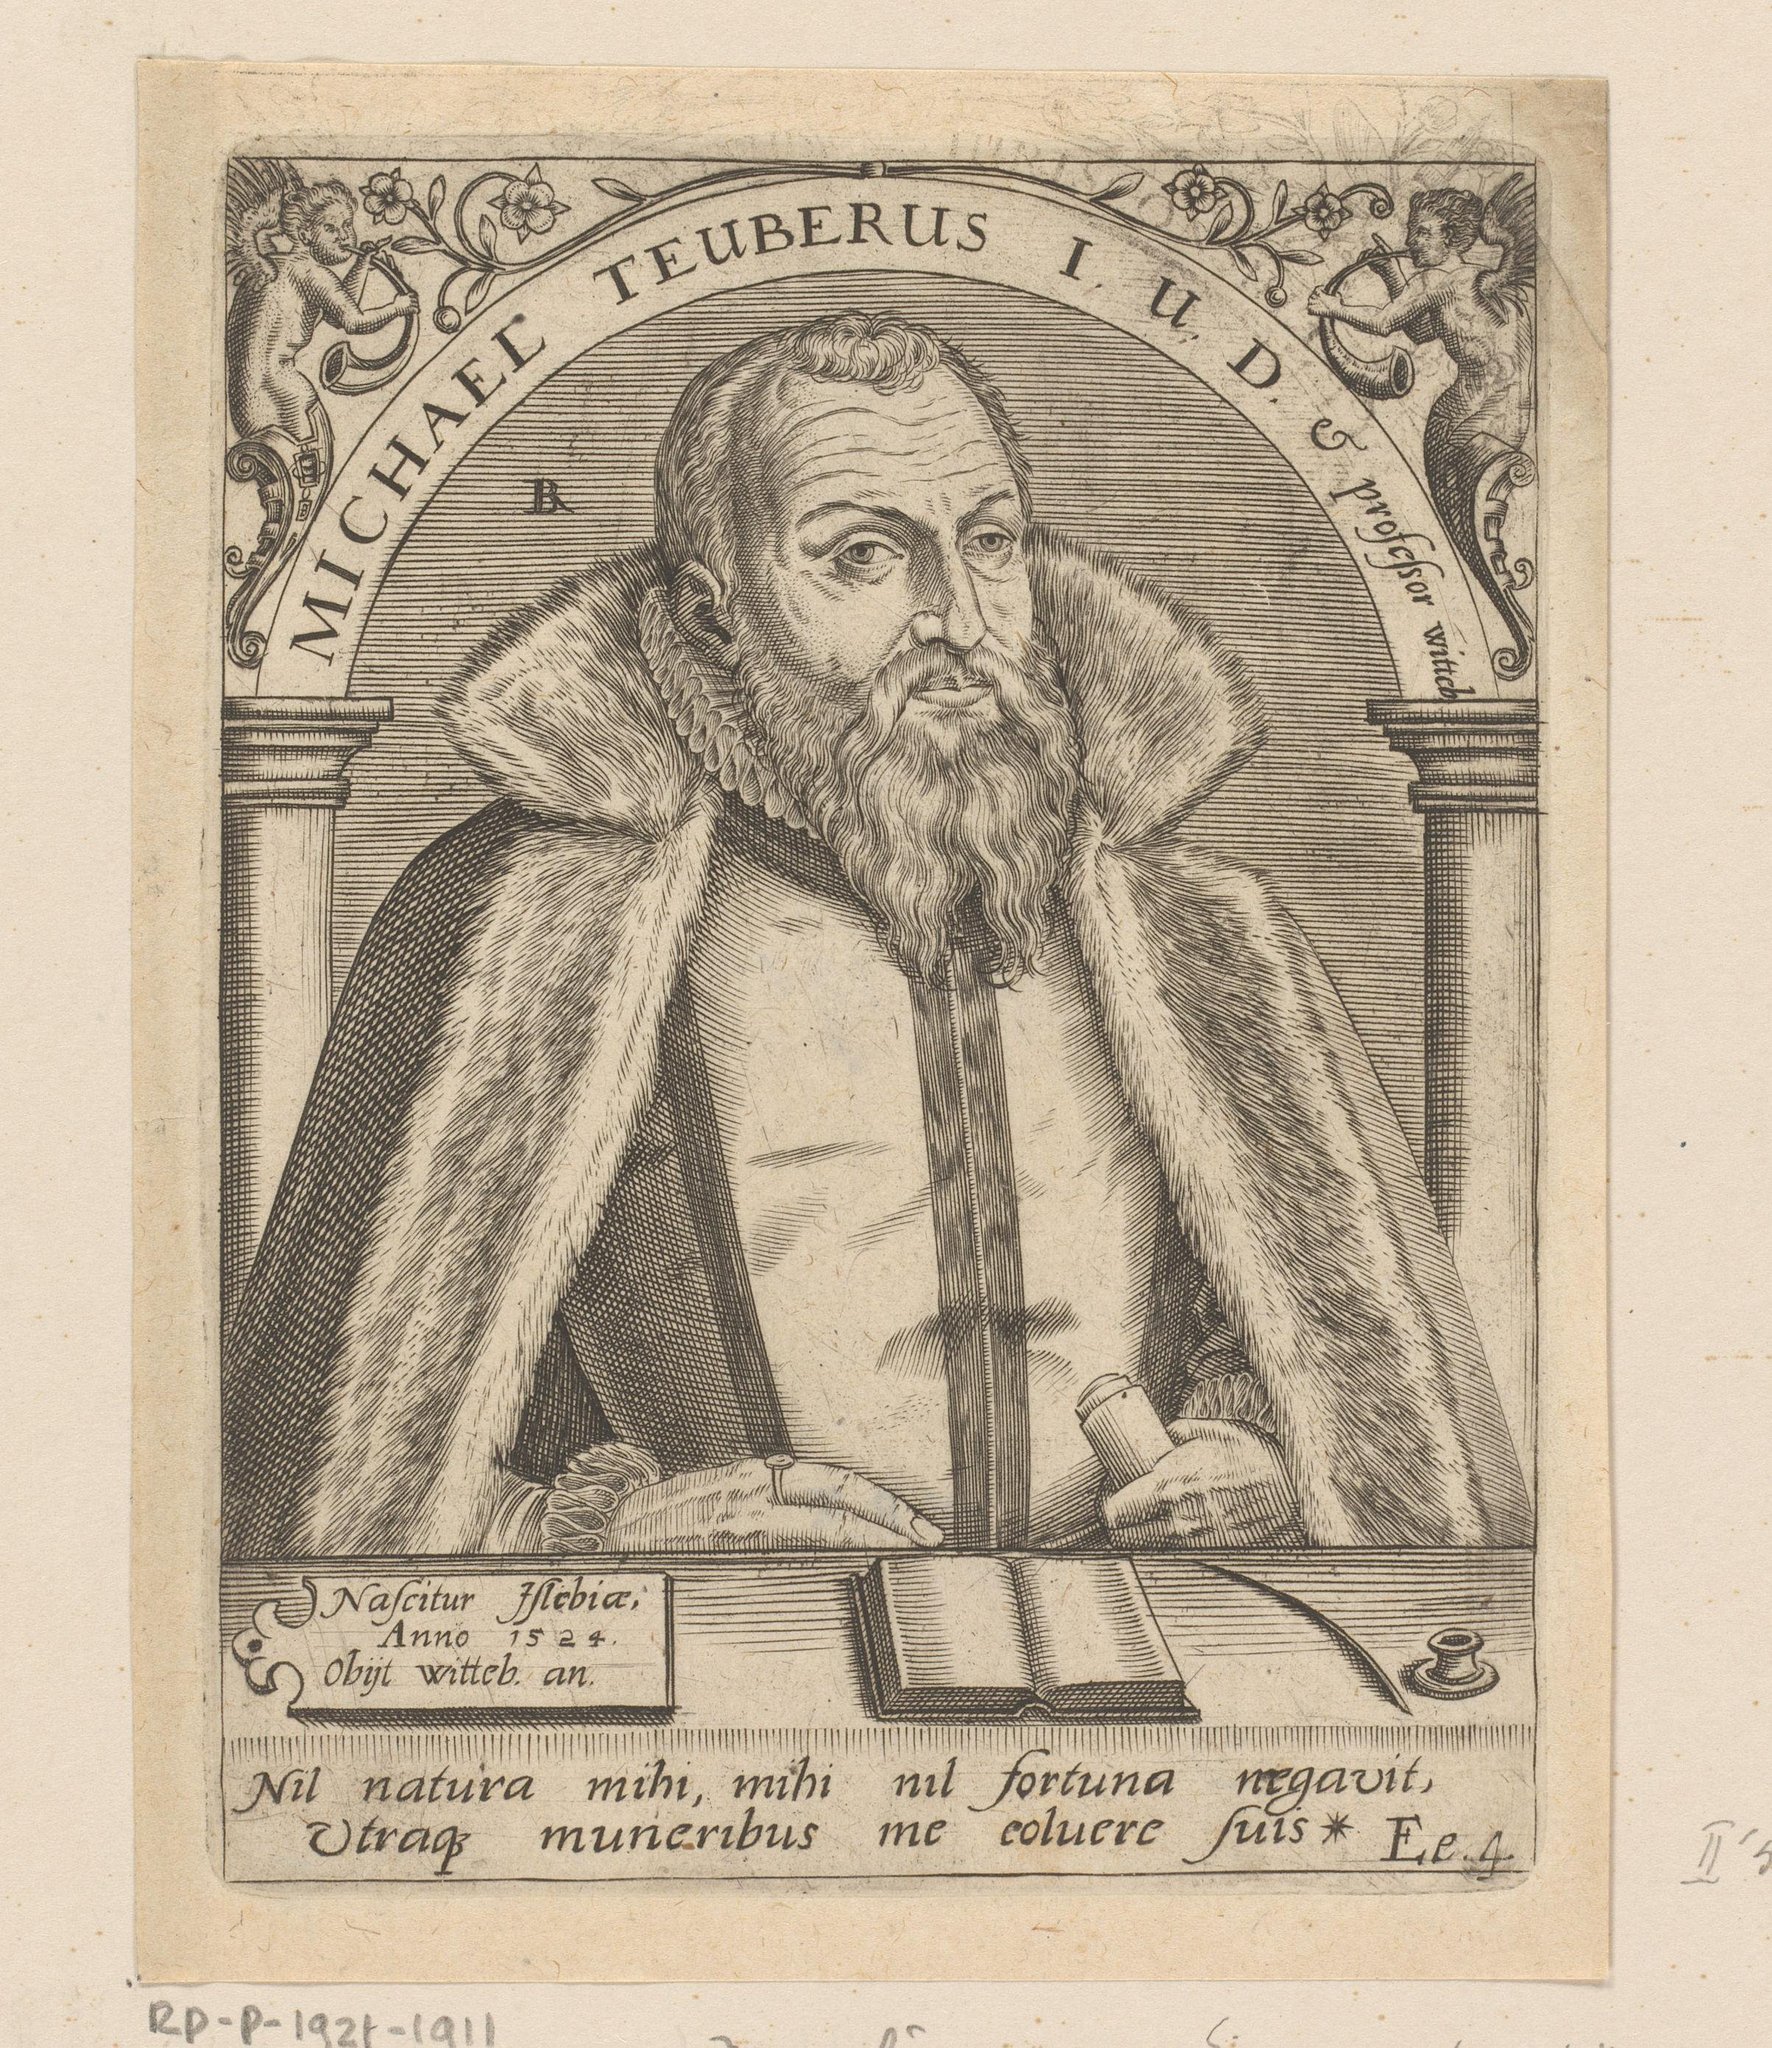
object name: book illustration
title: Michael Teuberus I.U.D. professor Witteb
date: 1650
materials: paper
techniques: engraving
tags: scholar, philosopher, historical persons, law and jurisprudence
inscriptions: collector's mark: Lugt 2233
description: Prent gebruikt in: Boissard, Jean Jacques. Bibliotheca chalcographica. 8 dln. Frankfurt am Main: Johannes Ammon, 1650-1652. Ook gebruikt in latere edities. Eerdere staat van prent verschenen in: Boissard, Jean Jacques. Icones quinquaginta virorum illustrium doctrina & eruditione praestantium ad vivum effictae. 4 dln. Frankfurt am Main: s.n., 1597-1599. Mogelijk ook gebruikt in latere edities.